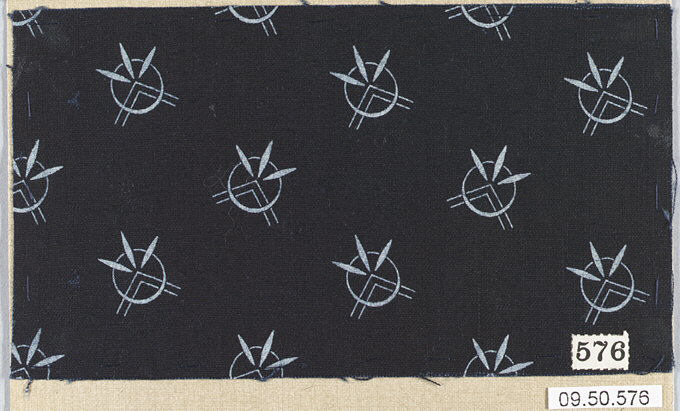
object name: piece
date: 1801-1900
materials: cotton